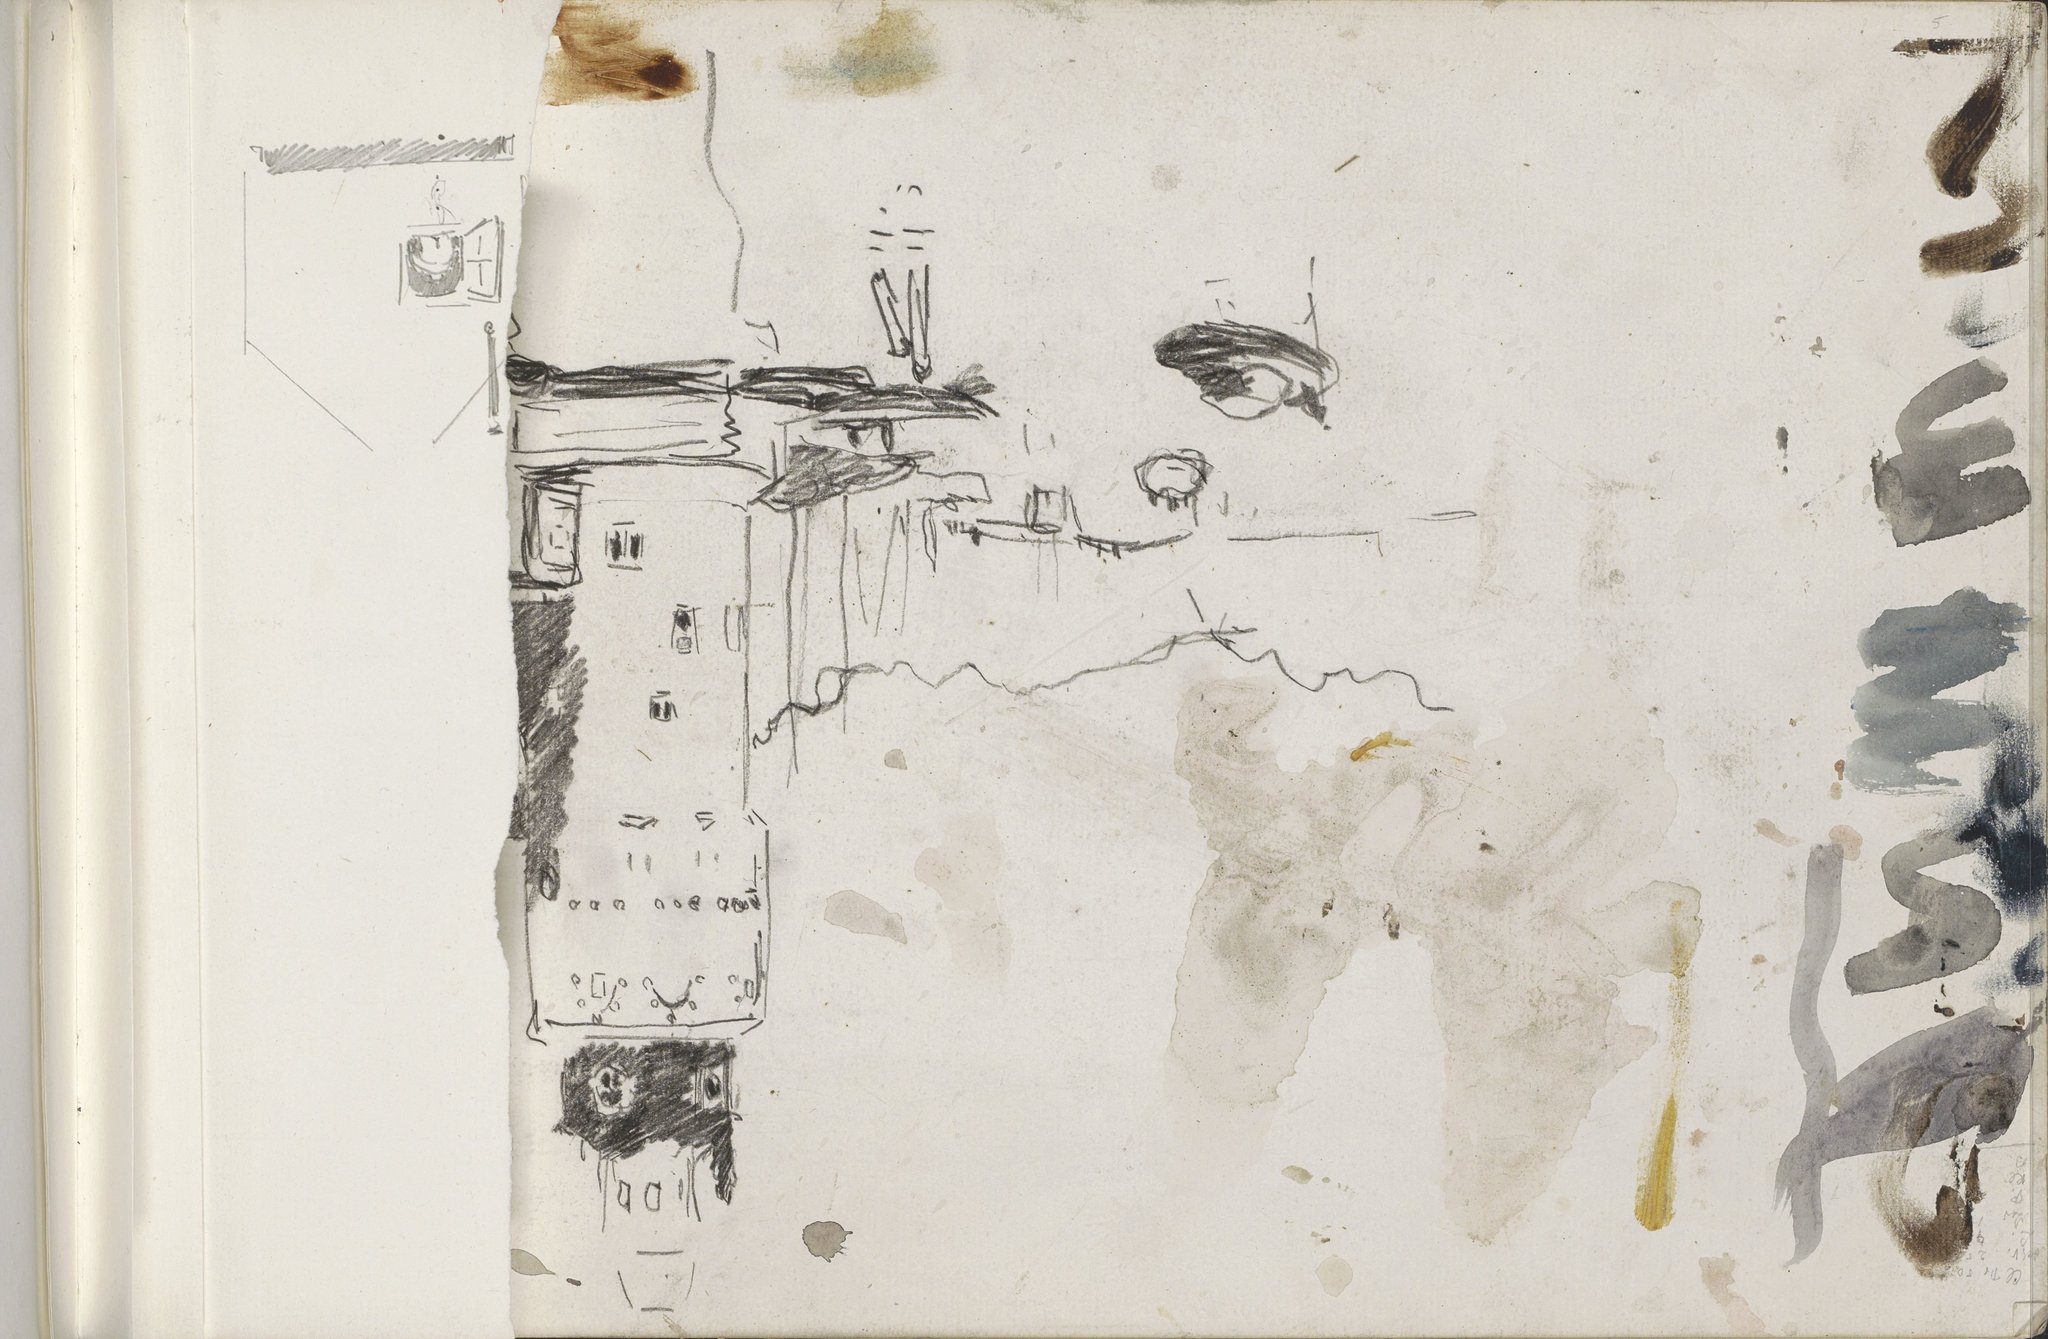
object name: sketchbook leaf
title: Huis met een geopend raam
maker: willem witsen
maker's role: draughtsman, painter, print maker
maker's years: 1860-1923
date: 1887-1892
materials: paper, pencil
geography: amsterdam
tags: urban housing, open window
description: Pagina 4A uit een schetsboek met 17 bladen.